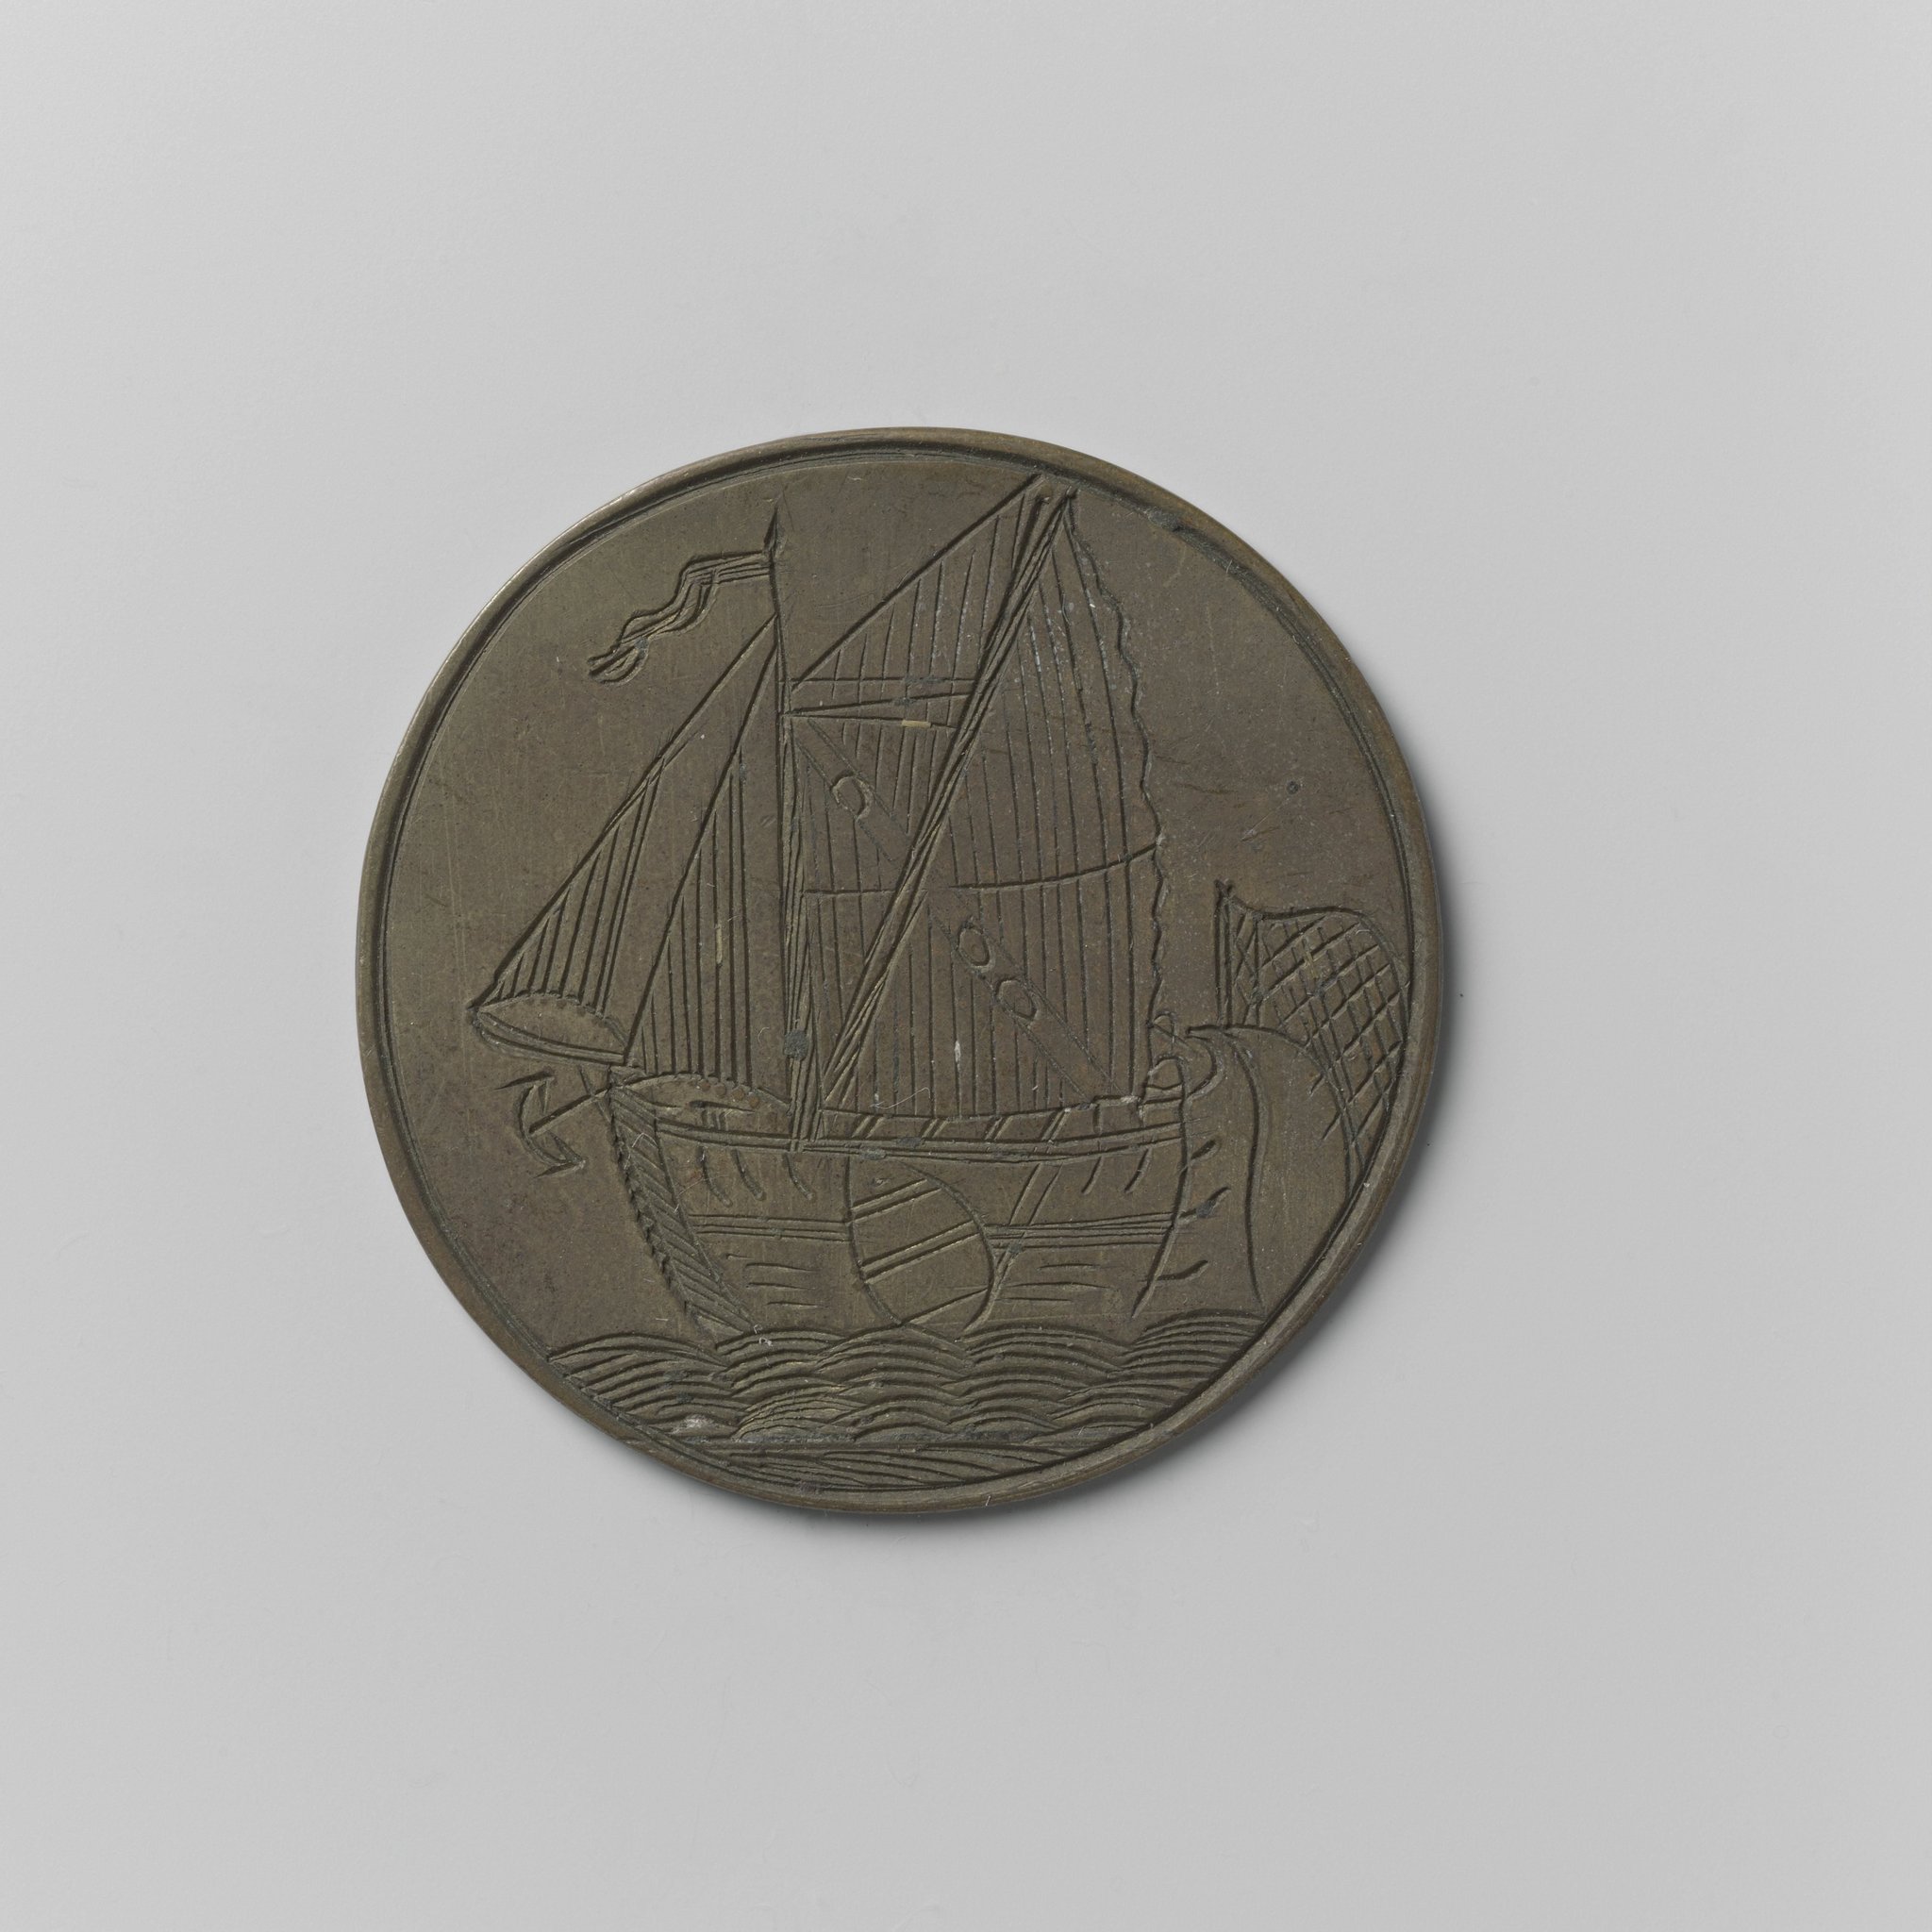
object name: medal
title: Klein binnenlandsvaardersgilde van Amsterdam, gildepenning van Johannis Leeseman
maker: Anonymous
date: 1807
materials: brass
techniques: engraving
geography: amsterdam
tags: amsterdam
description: Messing penning. Voorzijde: naar links varend schip; op achterplecht:gearceerde vlag. Keerzijde: opschrift